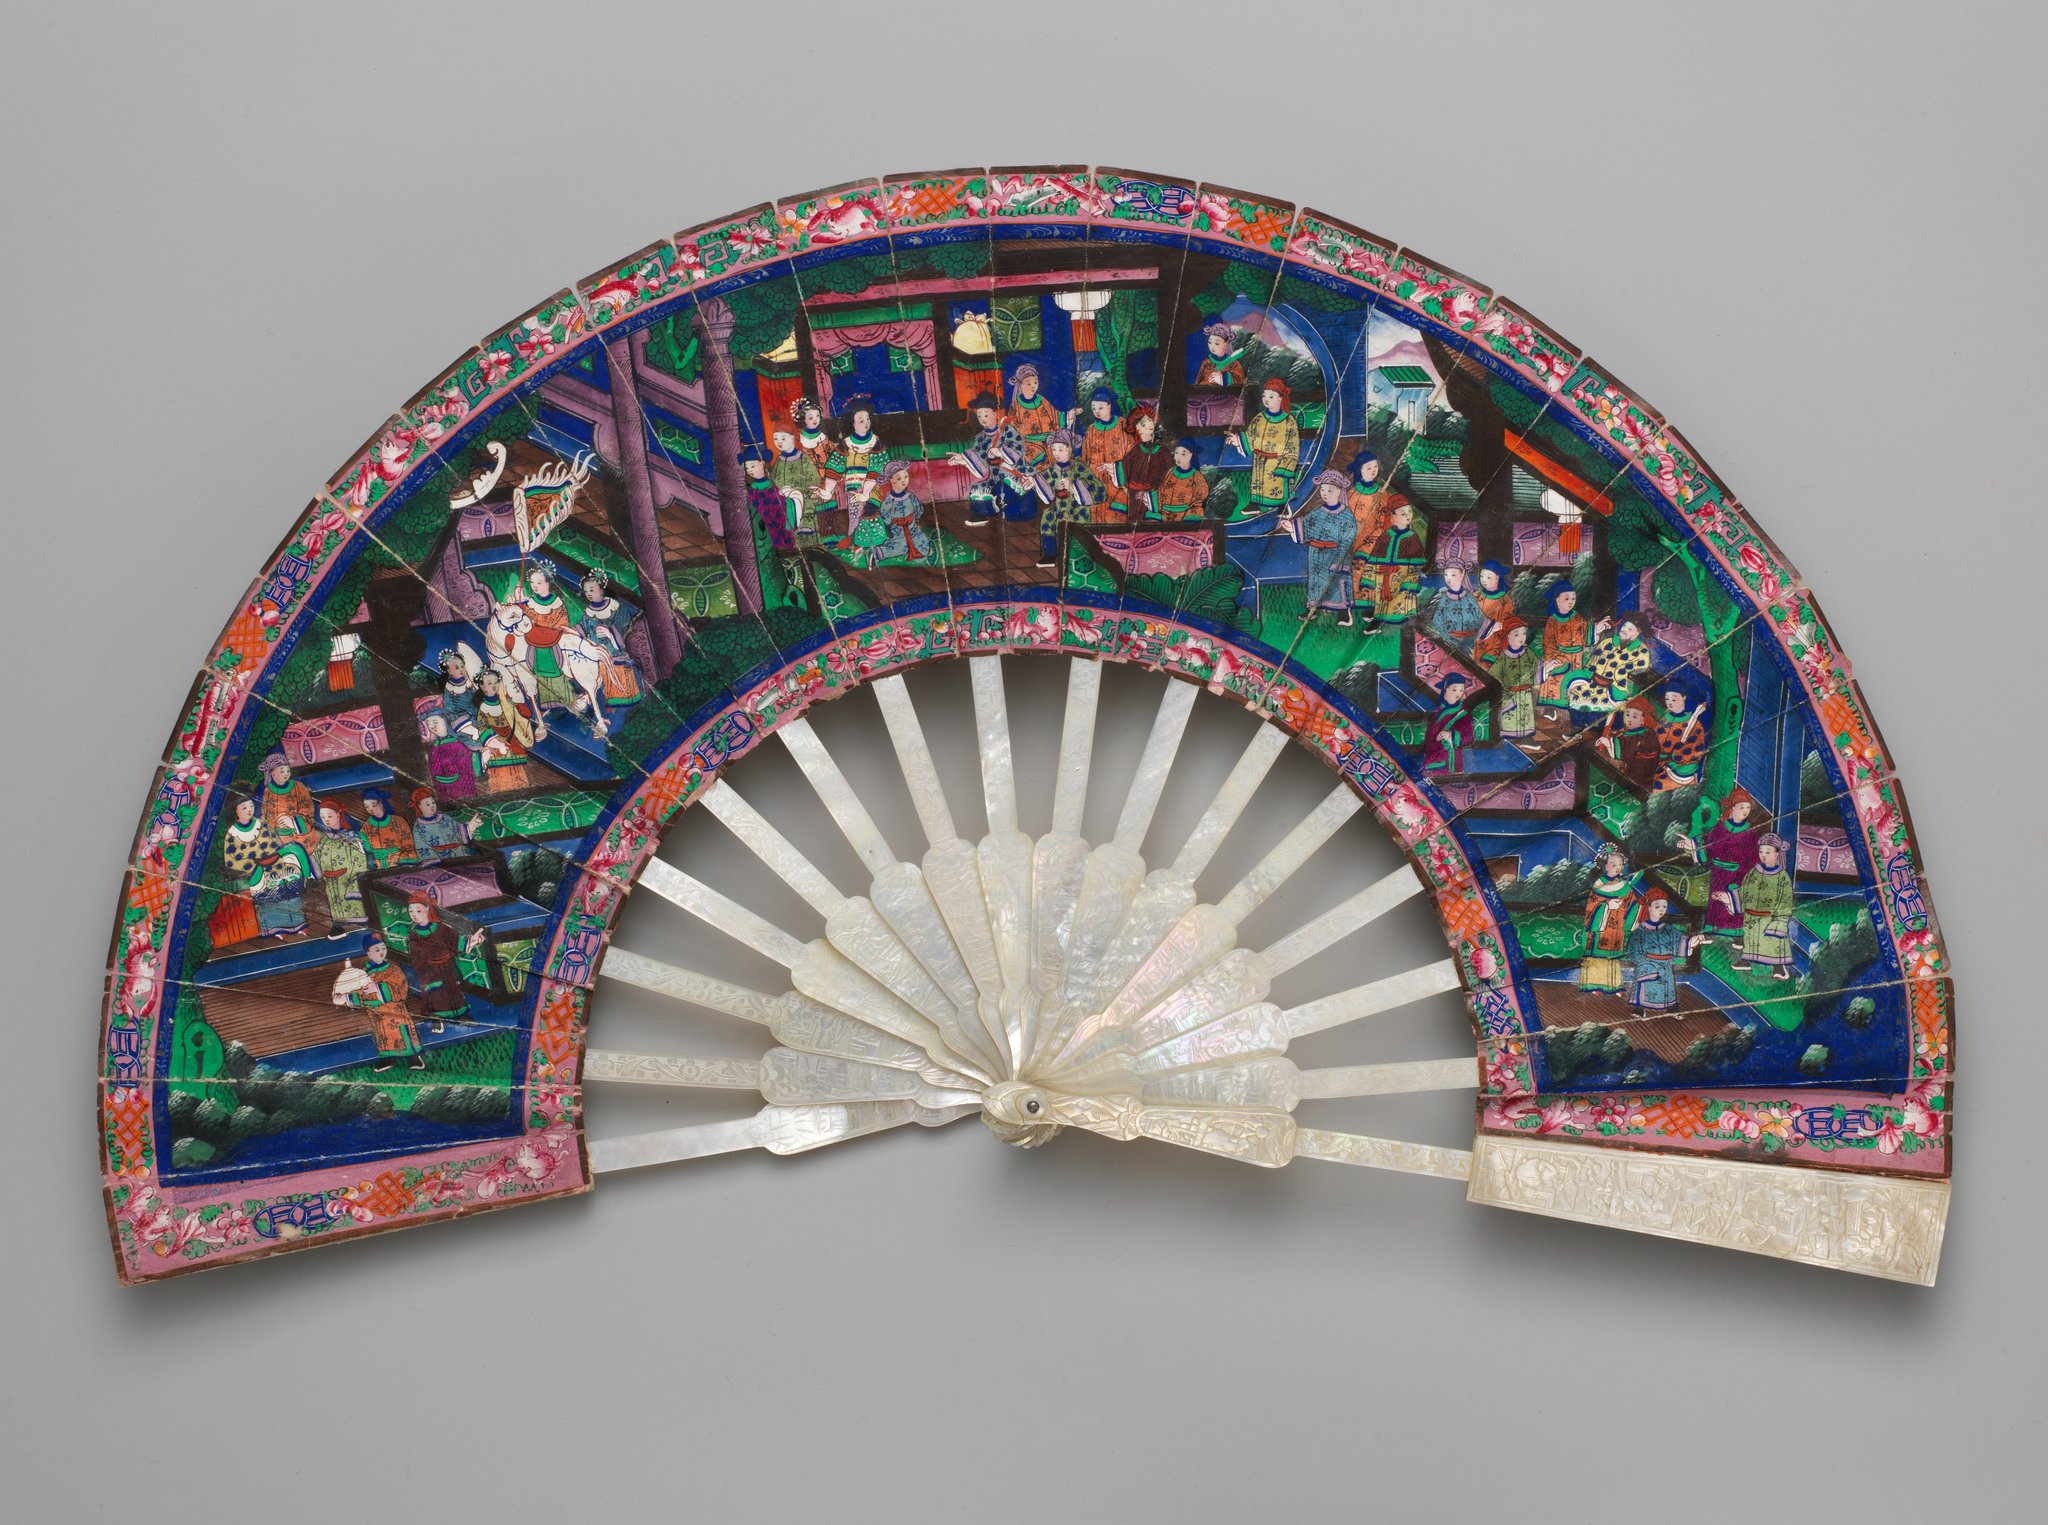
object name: fan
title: Folding Fan with Scene of Figures in a Courtyard Garden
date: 1801-1900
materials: mother of pearl, paper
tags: men,women,horses